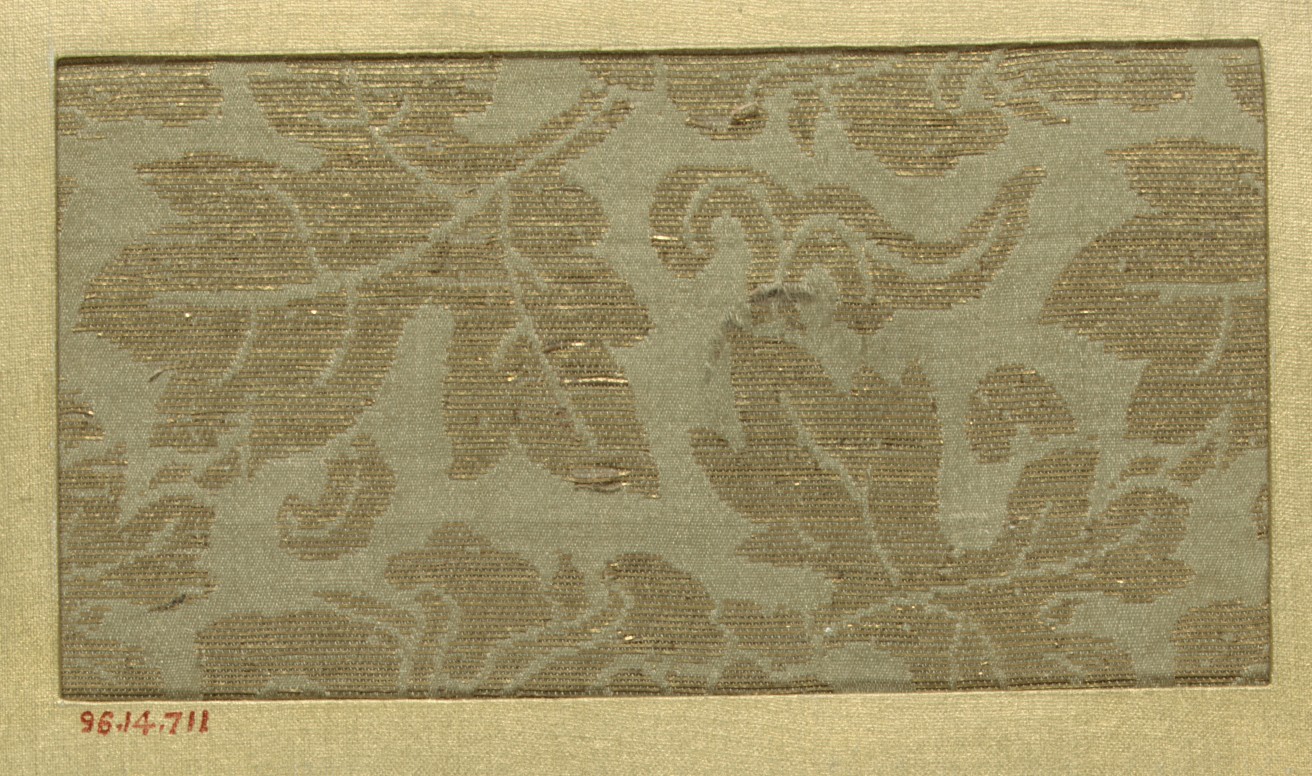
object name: piece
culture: japanese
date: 1701-1900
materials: silk